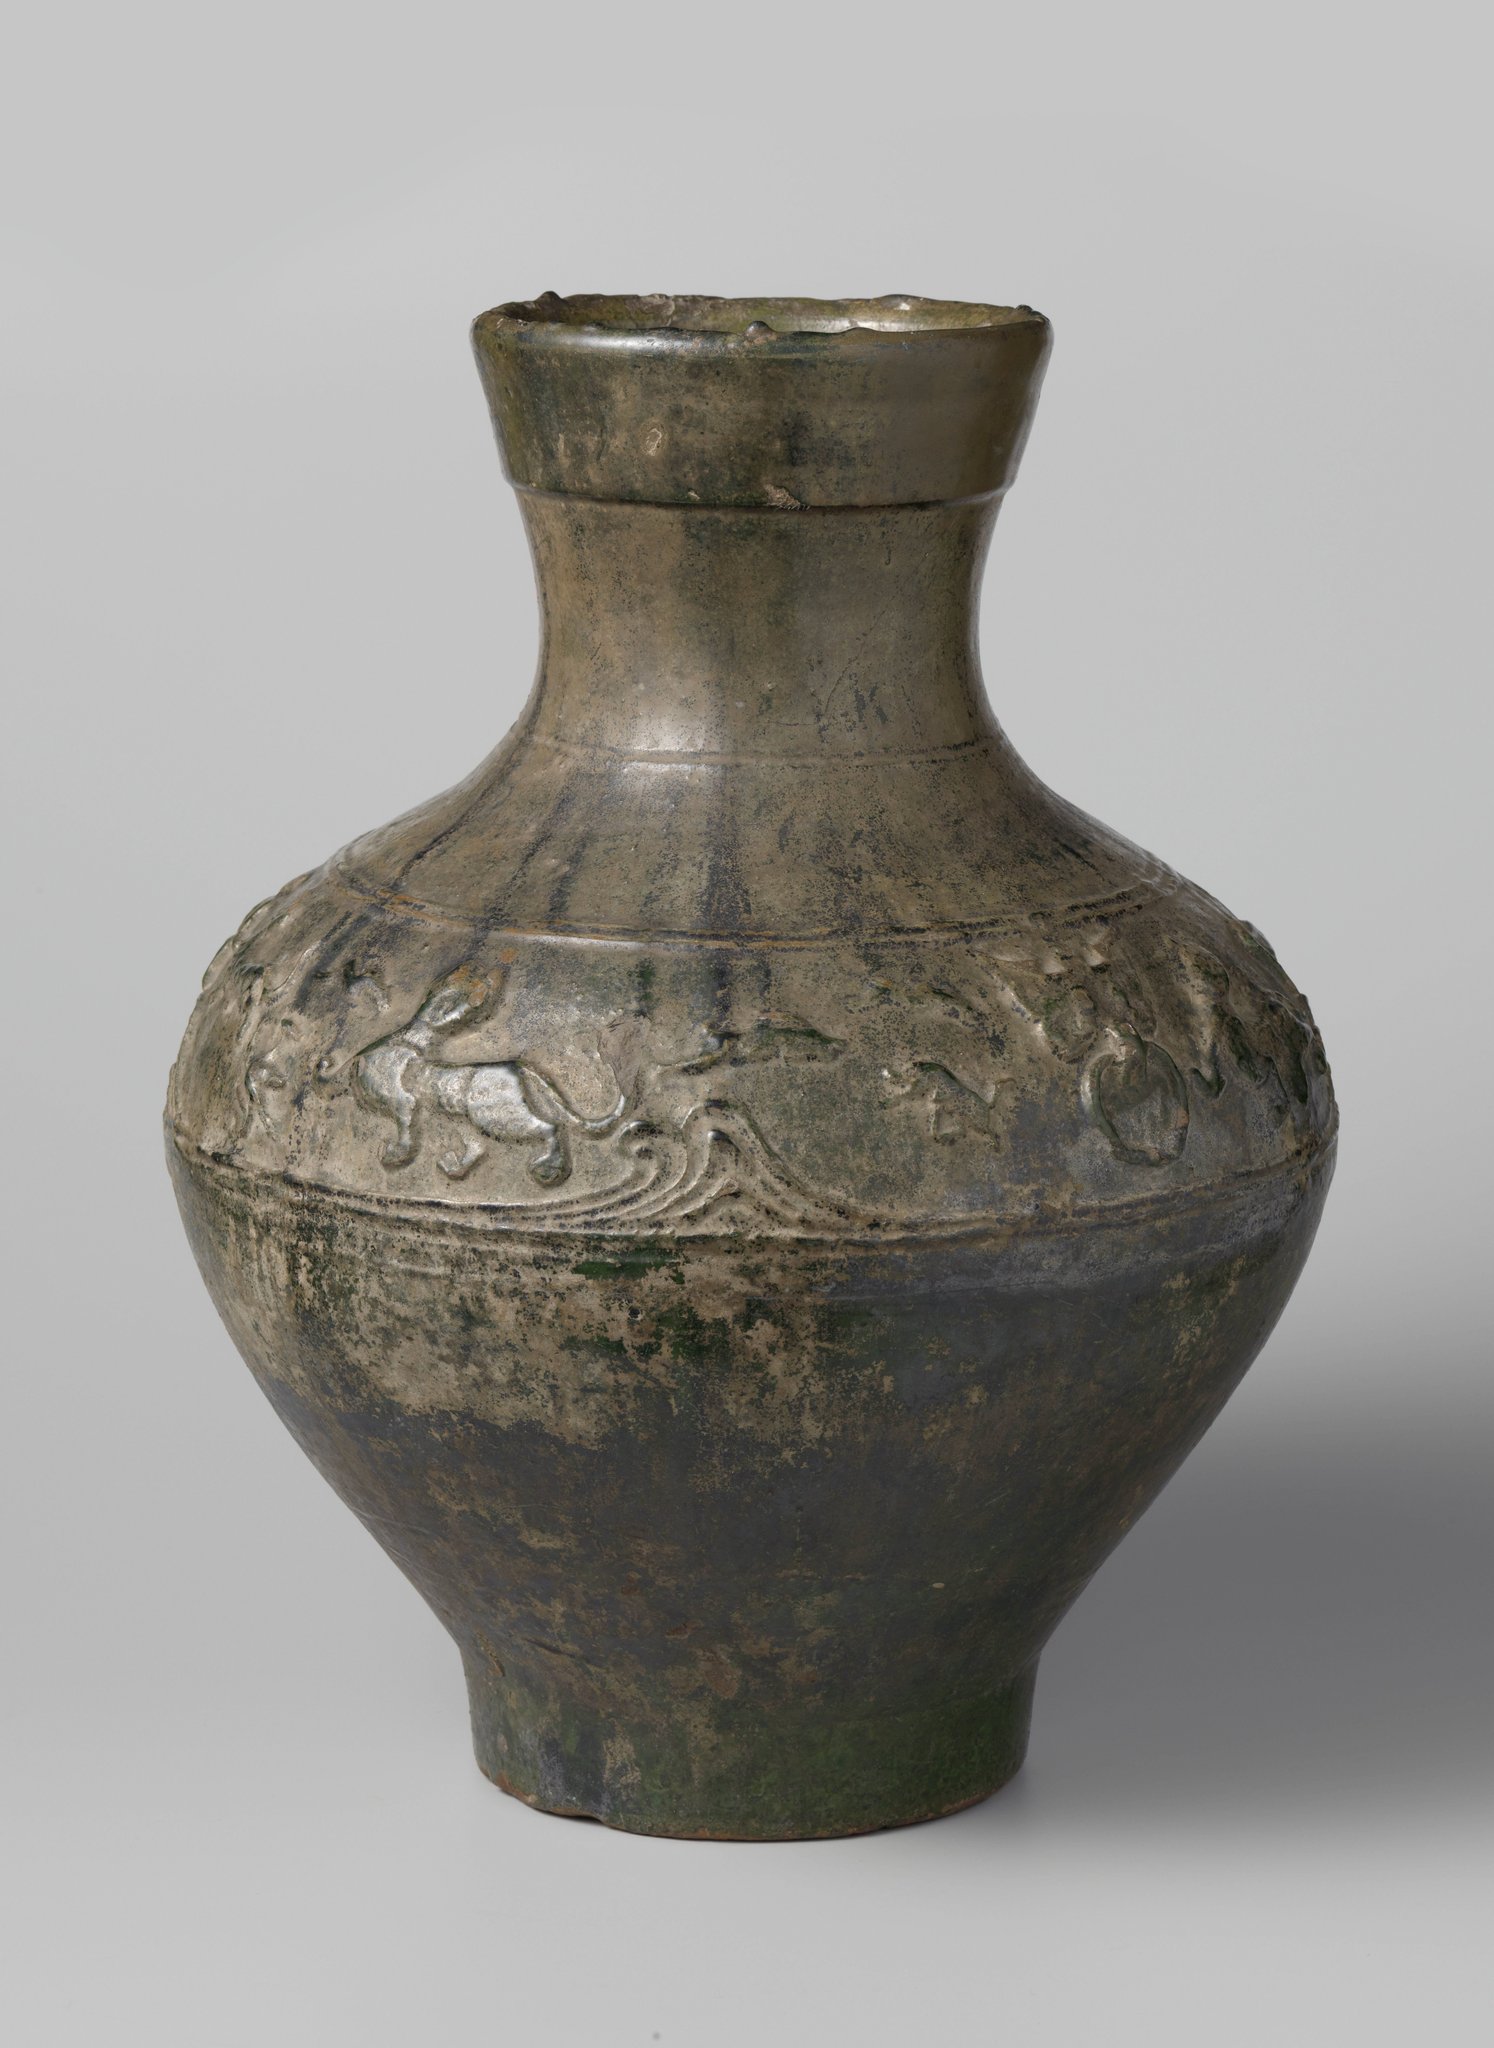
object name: vase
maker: Anonymous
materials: earthenware, glaze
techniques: firing, relief, turning, vitrification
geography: china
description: During the Han Dynasty ritual bronzes decreased in importance and pottery funerary objects took their place as grave goods. Such pottery greatly resembled its bronze prototypes and even imitated their handles. On the decorative band around the body of this vase is a hunting scene with leaping animals and hunters.